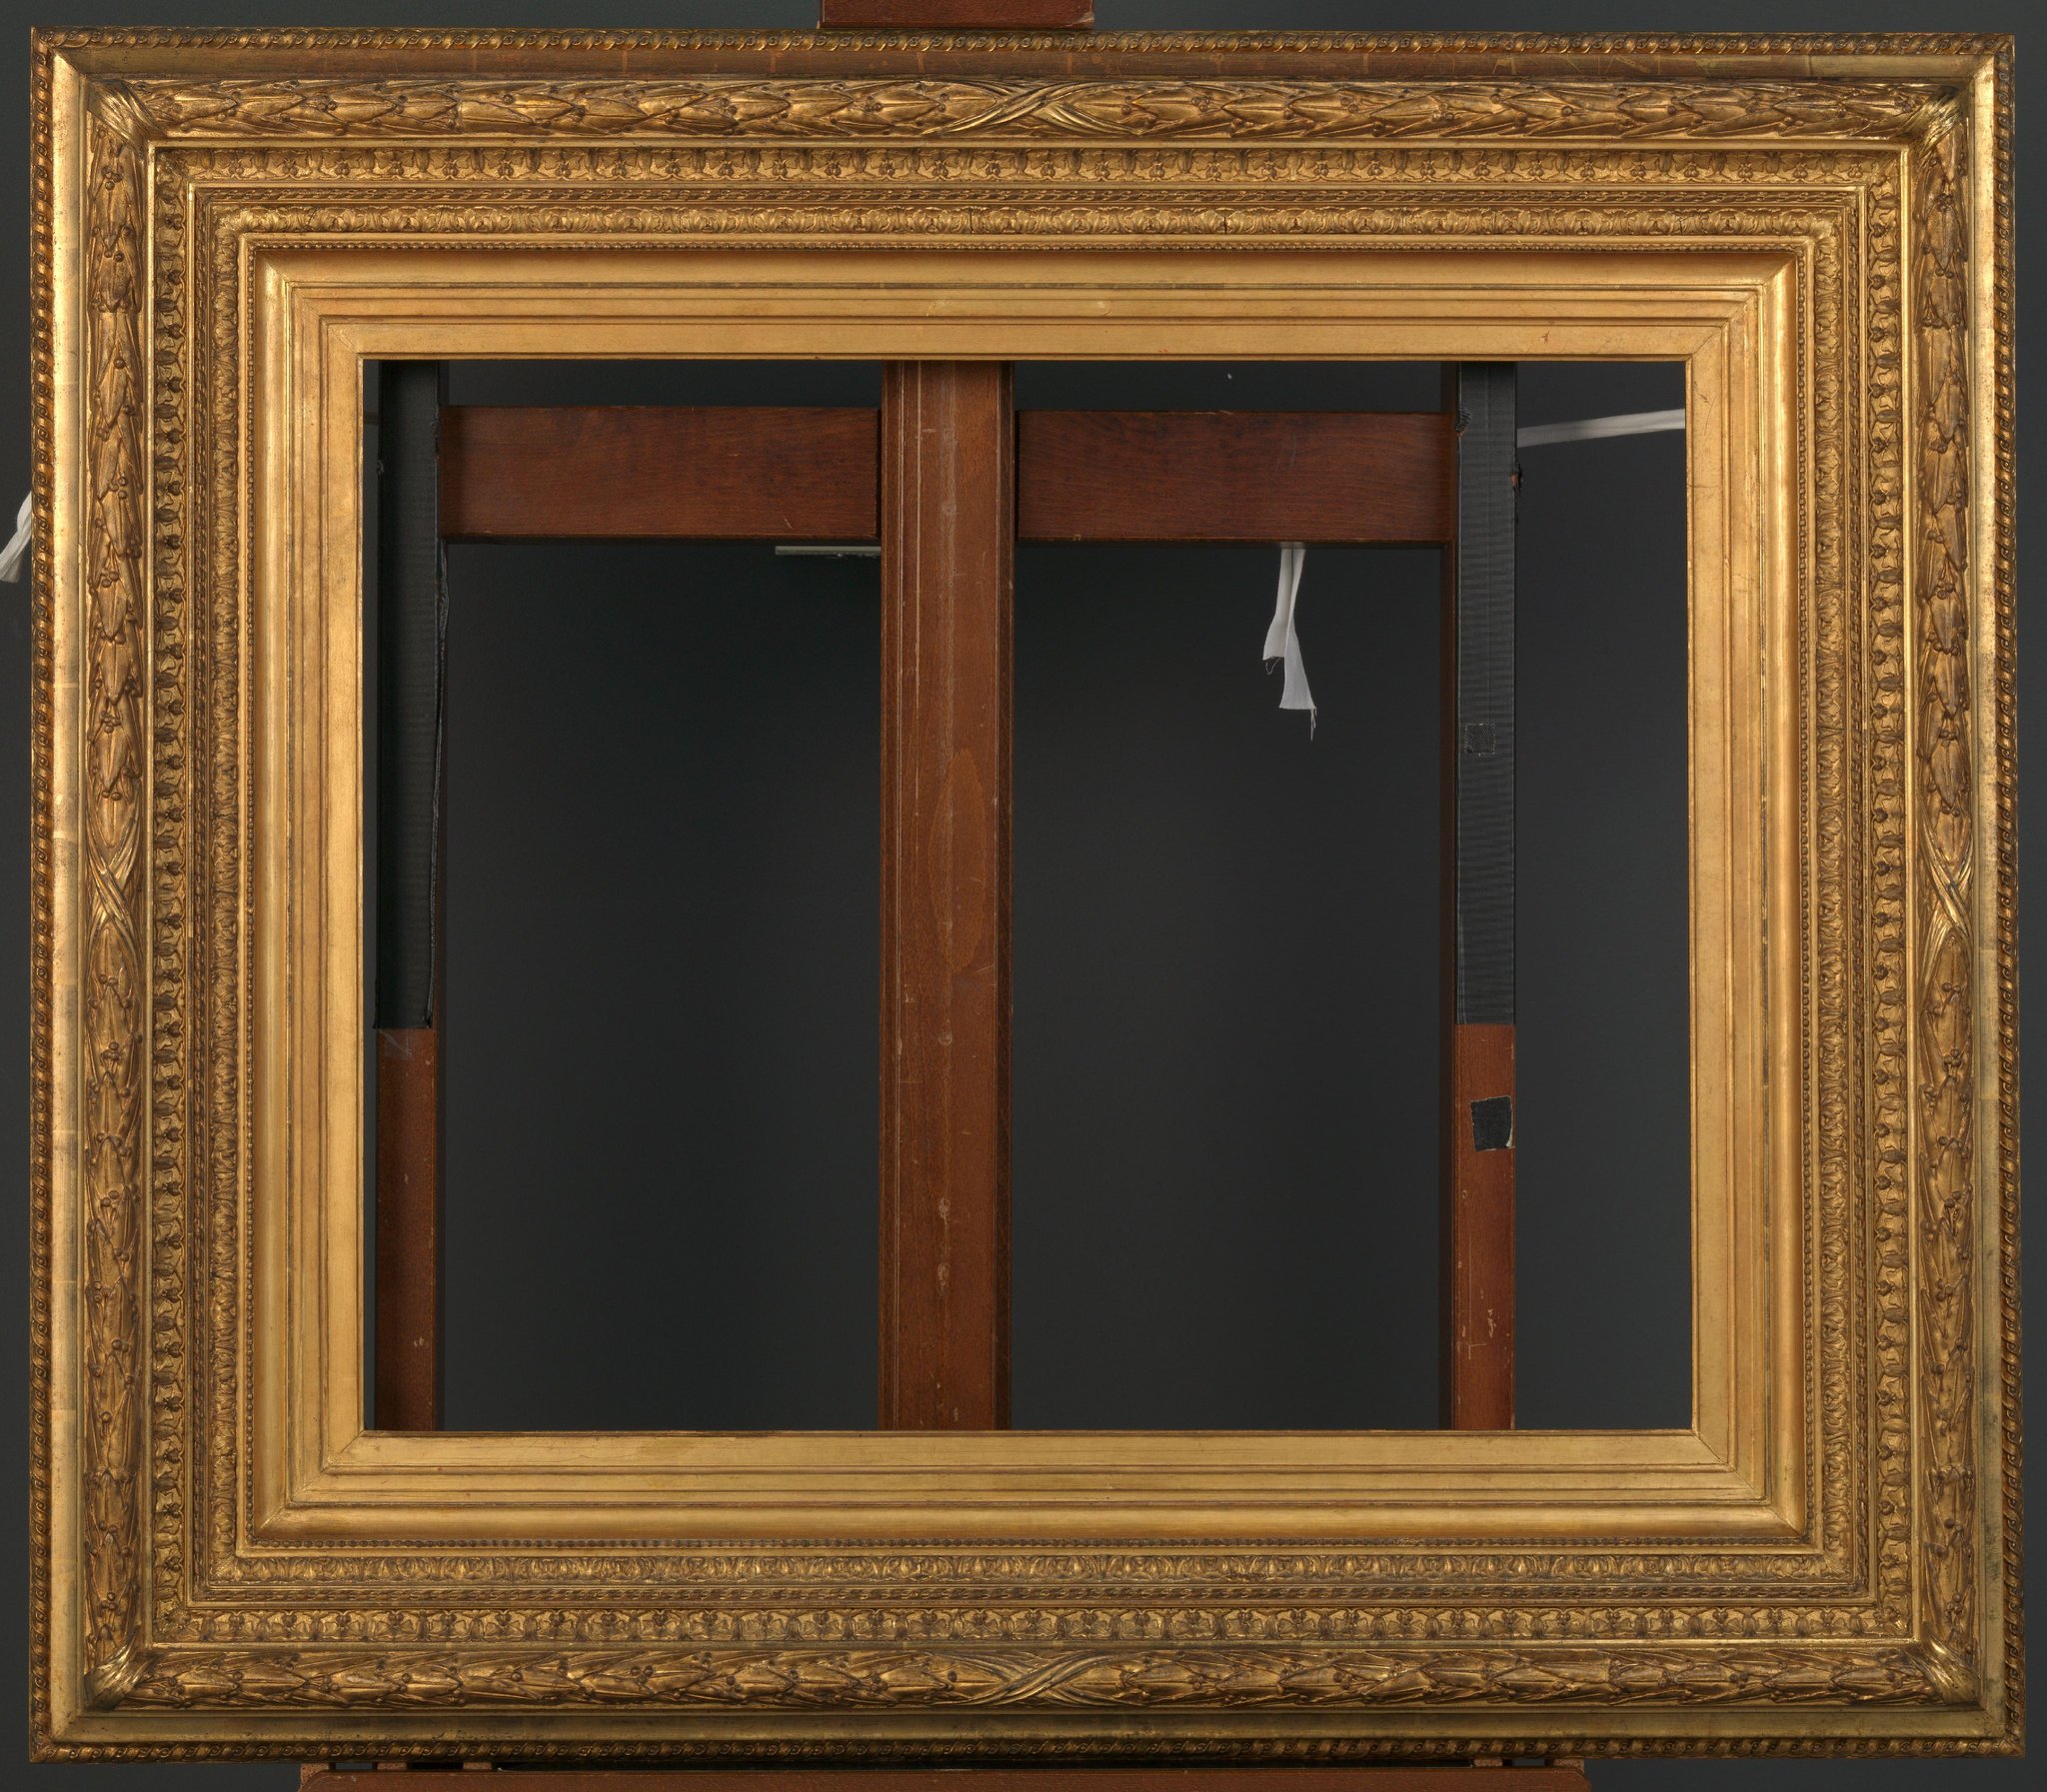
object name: frame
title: Vergulde lijst met pâte-ornamenten in neo-classicistische stijl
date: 1850-1899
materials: wood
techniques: oil gilded, gilding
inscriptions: plate, label: ‘728’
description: Van buiten naar binnen is de lijst als volgt opgebouwd: een buitenrand met daarop een vlechtband loopt over in een holle rug. Het hoogste punt van de lijst wordt gevormd door laurierstokken, met in het midden en op de verstekken gekruiste linten. Aan weerzijden van de laurierstokken bevindt zich een koofje. Vervolgens een holle keel met bladornamenten, die wordt gevolgd door een hoog bandje en aangrenzend een vlak profieldeel, waarop zich een getorst lint bevindt. Hierop volgt een tweede holle keel met bladornamenten, een koofje en een schuin bandje met daarop een kralenrandje. De kraaltjes zijn met elkaar verbonden middels een touwtje. De binnenste, ornamentloze, holle keel wordt gevolgd door een hoog bandje, twee vlakke profieldelen, een koofje en een vlakke binnenlijst die eindigt in een koofje.